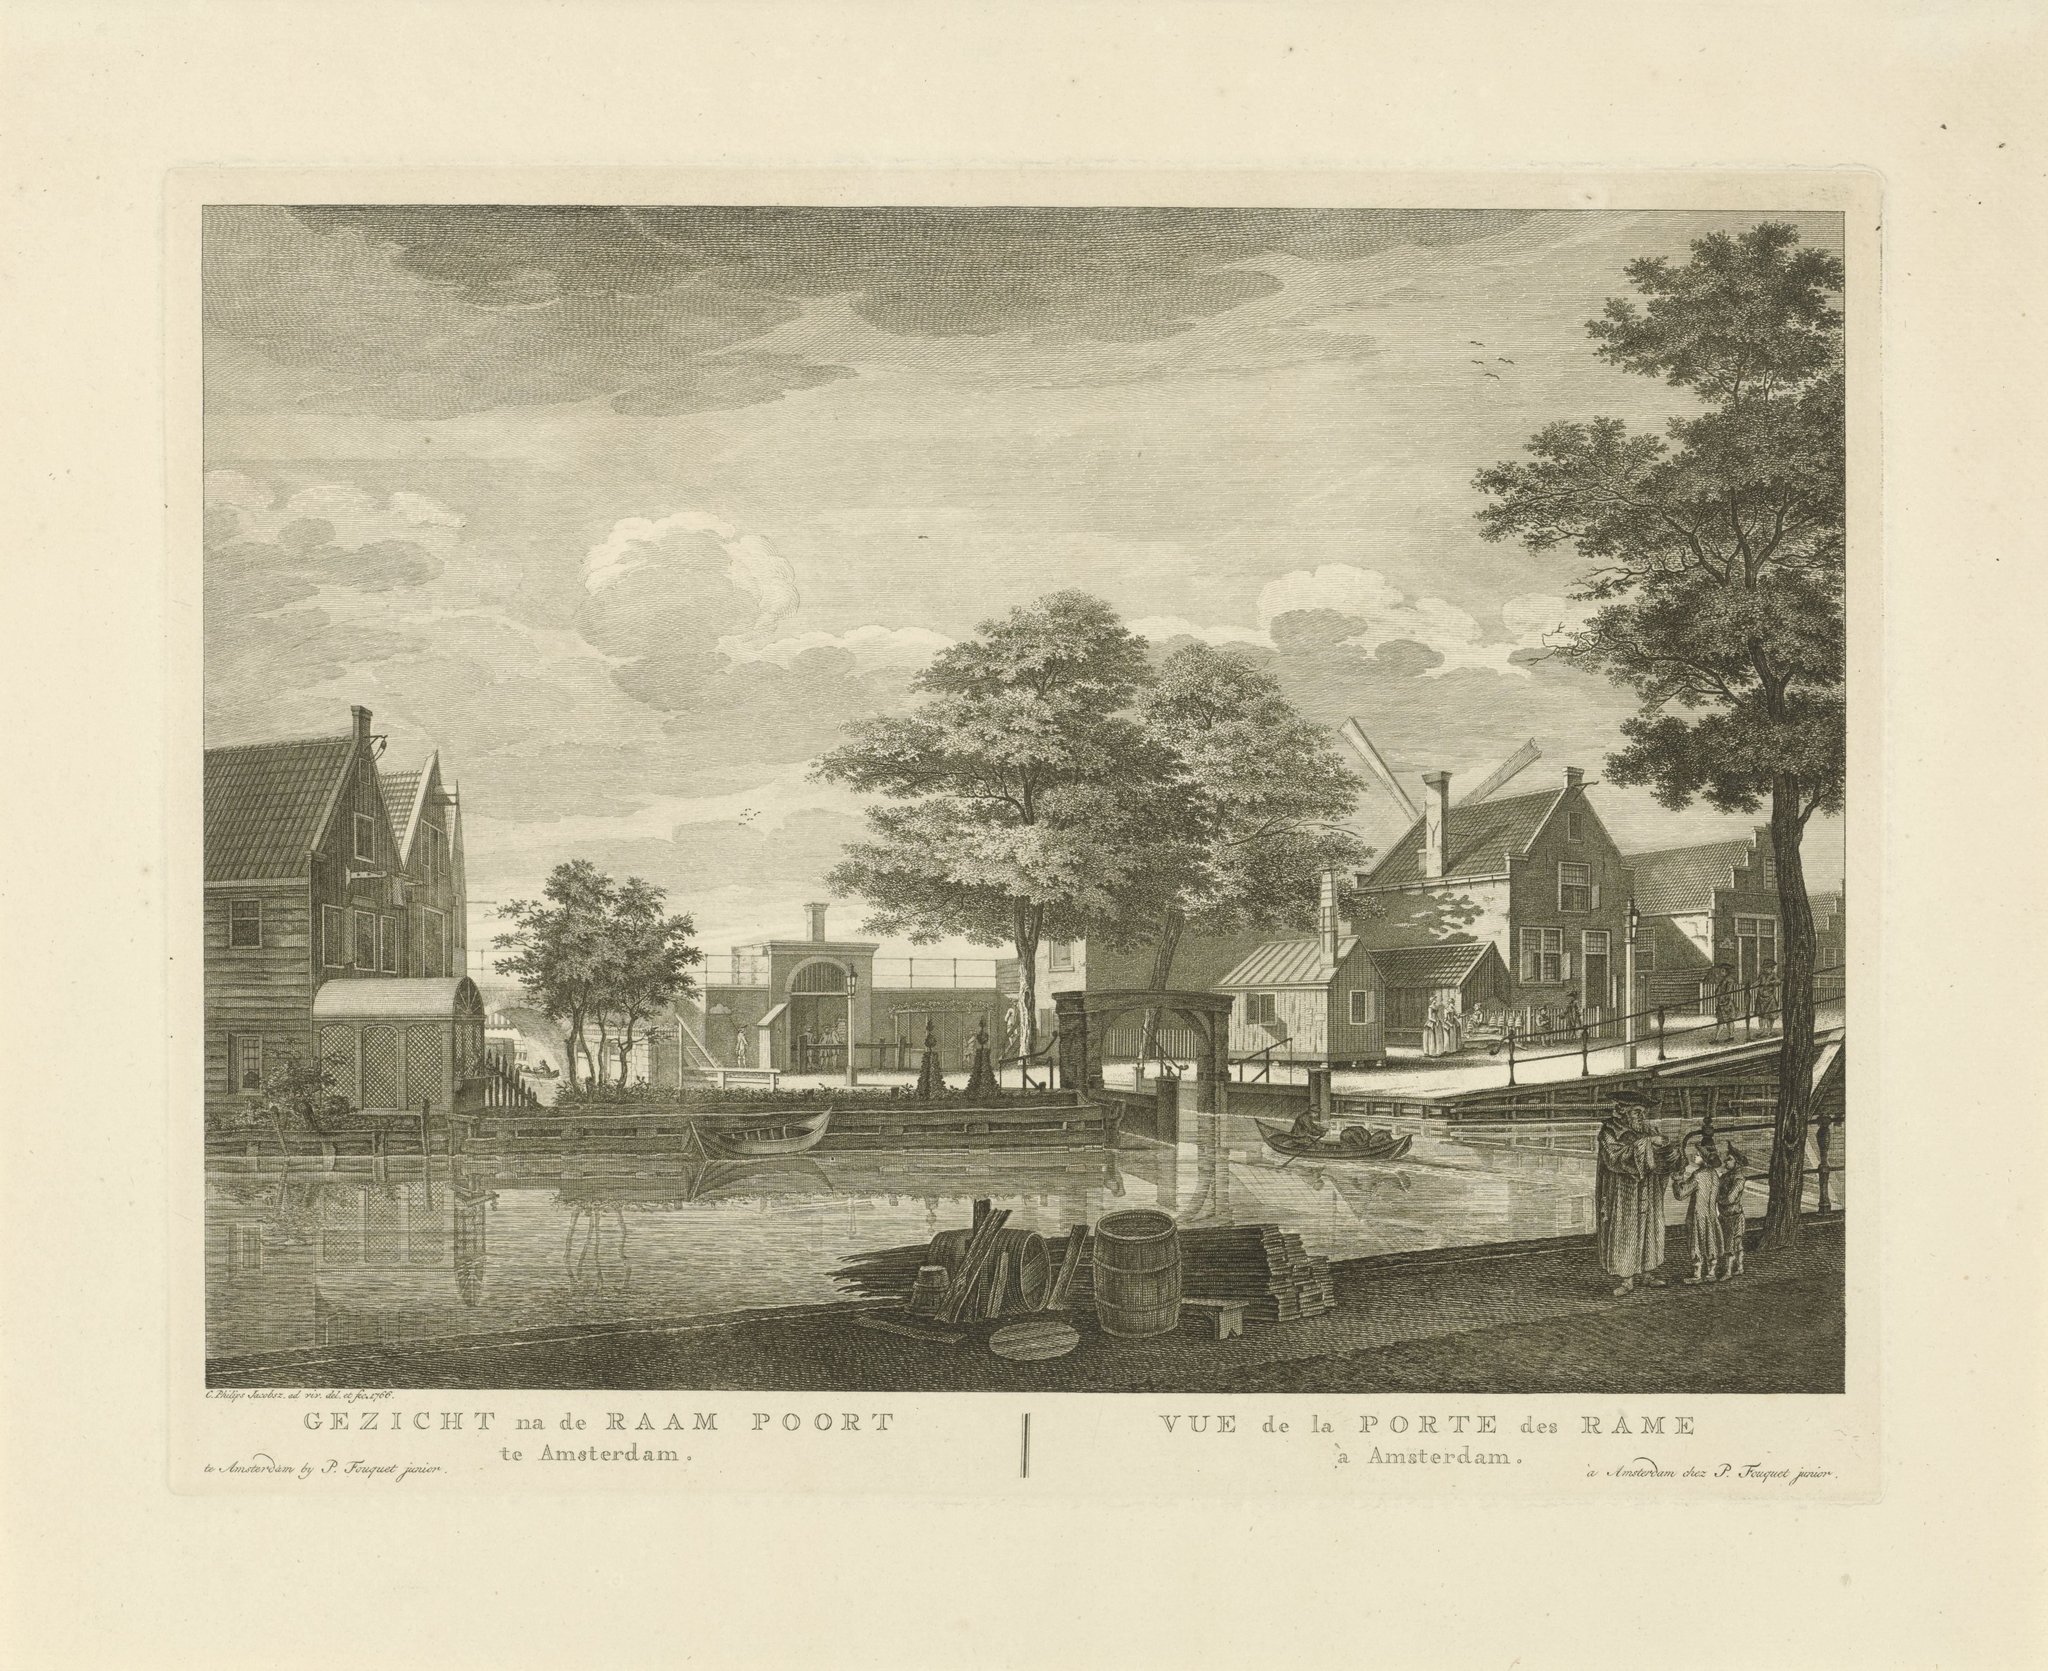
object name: print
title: Gezicht na de Raam Poort te Amsterdam / Vue de la Porte des Rame à Amsterdam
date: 1766-1783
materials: paper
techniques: engraving, etching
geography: amsterdam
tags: city-gate, canals, waters (in city) (+ city(-scape) with figures, staffage), street (+ city(-scape) with figures, staffage)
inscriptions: collector's mark: Lugt 2228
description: Deze prent is ook gebruikt in de zogenaamde Atlas van Fouquet.* Pierre Fouquet gaf vanaf 1760 stadsgezichten van Amsterdam - naar tekeningen van verschillende kunstenaars, gemaakt door verschillende prentmakers - uit. Deze prenten werden aanvankelijk los of in series verkocht. Zoals toen gebruikelijk kon de koper de prenten zelf laten inbinden. Hiertoe gaf Fouquet tussen 1778 en 1783 een titelblad, plattegrond en inhoudsopgave van de tot dusver 100 uitgegeven prenten uit (1). Gezien de inhoud afhankelijk was van wat de koper had verzameld verschilt de inhoud van de verschillende bewaarde Fouquetatlassen onder deze titel sterk. Ook zijn er exemplaren bekend waar tevens andere prenten aan zijn toegevoegd. Omdat er behoefte bleek aan uitleg bij de platen werd in 1783 een nieuwe versie van de atlas uitgegeven, aangevuld met tekst en twee prenten. De aangegeven volgorde veranderde maar de platen van de al eerder uitgegeven prenten bleven ongewijzigd. Deze uitgave werd in opdracht van Fouquet gedrukt bij Daniël Jean Changuion en Petrus den Hengst (2). Een tiental platen werd bijgewerkt en verscheen, met nieuw impressum, in het vervolg van Wagenaars geschiedenis van Amsterdam, uitgeven door Petrus Conradi en Folkert van der Plaats (3). Een aantal jaar na het overlijden van Fouquet kwam Evert Maaskamp met een nieuwe uitgave van de atlas, met verbeterde tekst en toevoeging van twee prenten. Op alle platen verwijderde hij het oude en liet hij zijn eigen impressum zetten (4). De huidige staat van de prent komt voor in exemplaren van de onder (1) en (2) genoemde werken. * Onder de Atlas van Fouquet of Fouquetatlas verstaan we de hieronder vermelde publicaties (1), (2) en (4). (1). Afbeeldingen van de wyd-vermaarde koopstad Amsterdam benevens des zelvs voornaamste gebouwen en gezigten alle naar het leeven getekend / Receuil des edifices les plus considerables et des plus belles vues, de la fameuse ville d'Amsterdam, dessinées d'après nature. Amsterdam: Pierre Fouquet, 1778-1783. (2). Nieuwe atlas, van de voornaamste gebouwen en gezigten der stad Amsterdam, met derzelver beknopte beschryvingen. 2 delen. Amsterdam: Daniël Jean Changuion en Petrus den Hengst [in opdracht van Pierre Fouquet], 1783. (3). Stijl, Simon. Amsterdam, in zyne geschiedenissen, voorregten, koophandel, gebouwen, kerkenstaat, schoolen, schutterye, gilden en regeeringe, beschreeven. Om te dienen ten vervolge op het werk van Jan Wagenaar (…). 10 delen. Amsterdam en Harlingen: Petrus Conradi en Folkert van der Plaats, 1788-1801. (4). Nieuwe atlas, van de voornaamste gebouwen en gezigten der stad Amsterdam. Met derzelver beknopte beschryvingen. Amsterdam: Evert Maaskamp, 1805. * Het aantal vermelde staten is gebaseerd op het aantal gevonden staten. Mogelijk zijn er meer staten van deze prent. Voor tweede bekende staat zie RP-P-AO-27-6A.